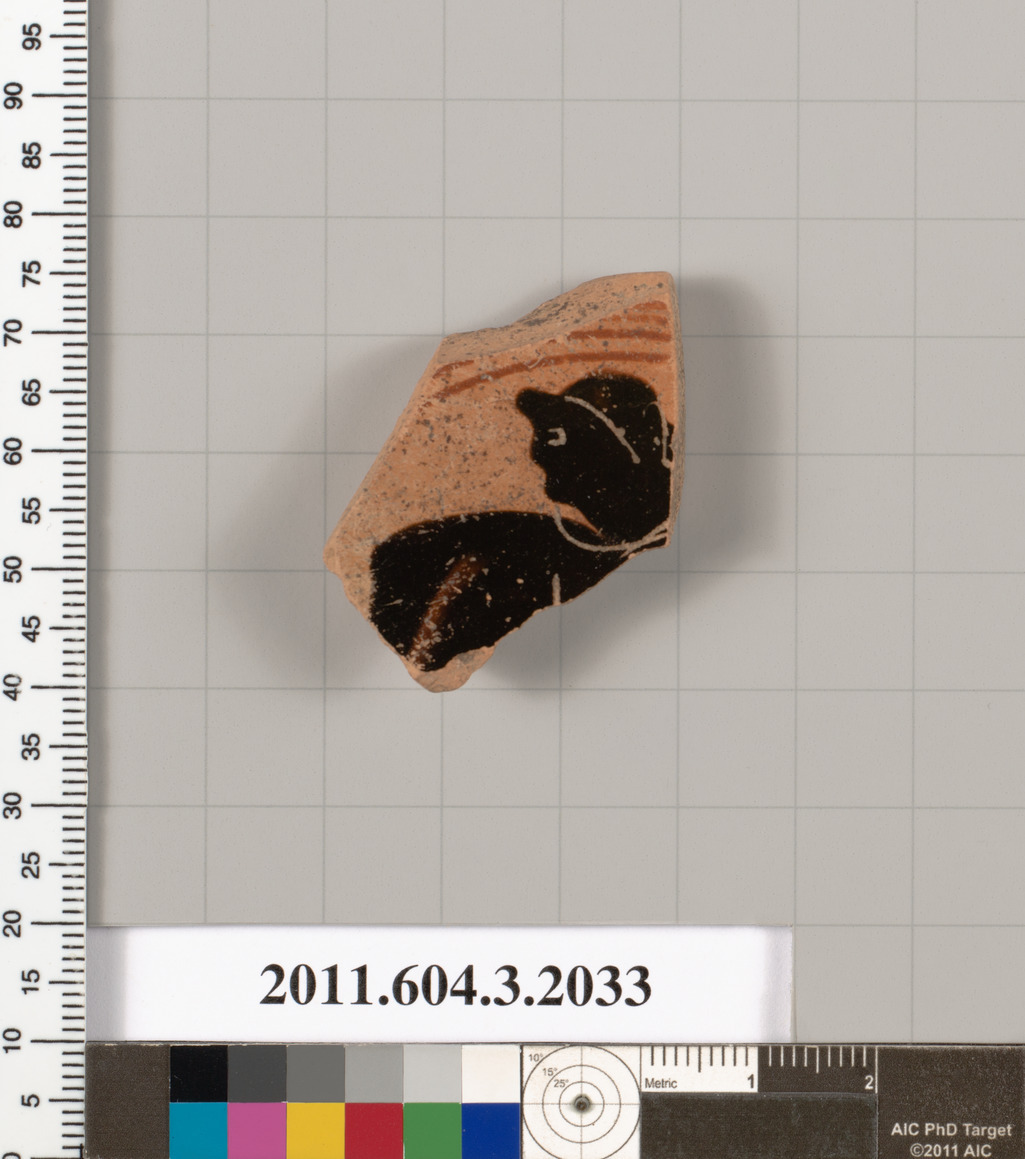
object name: kylix fragment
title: Terracotta fragment of a kylix (drinking cup)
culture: greek, attic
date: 500-468 BCE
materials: terracotta